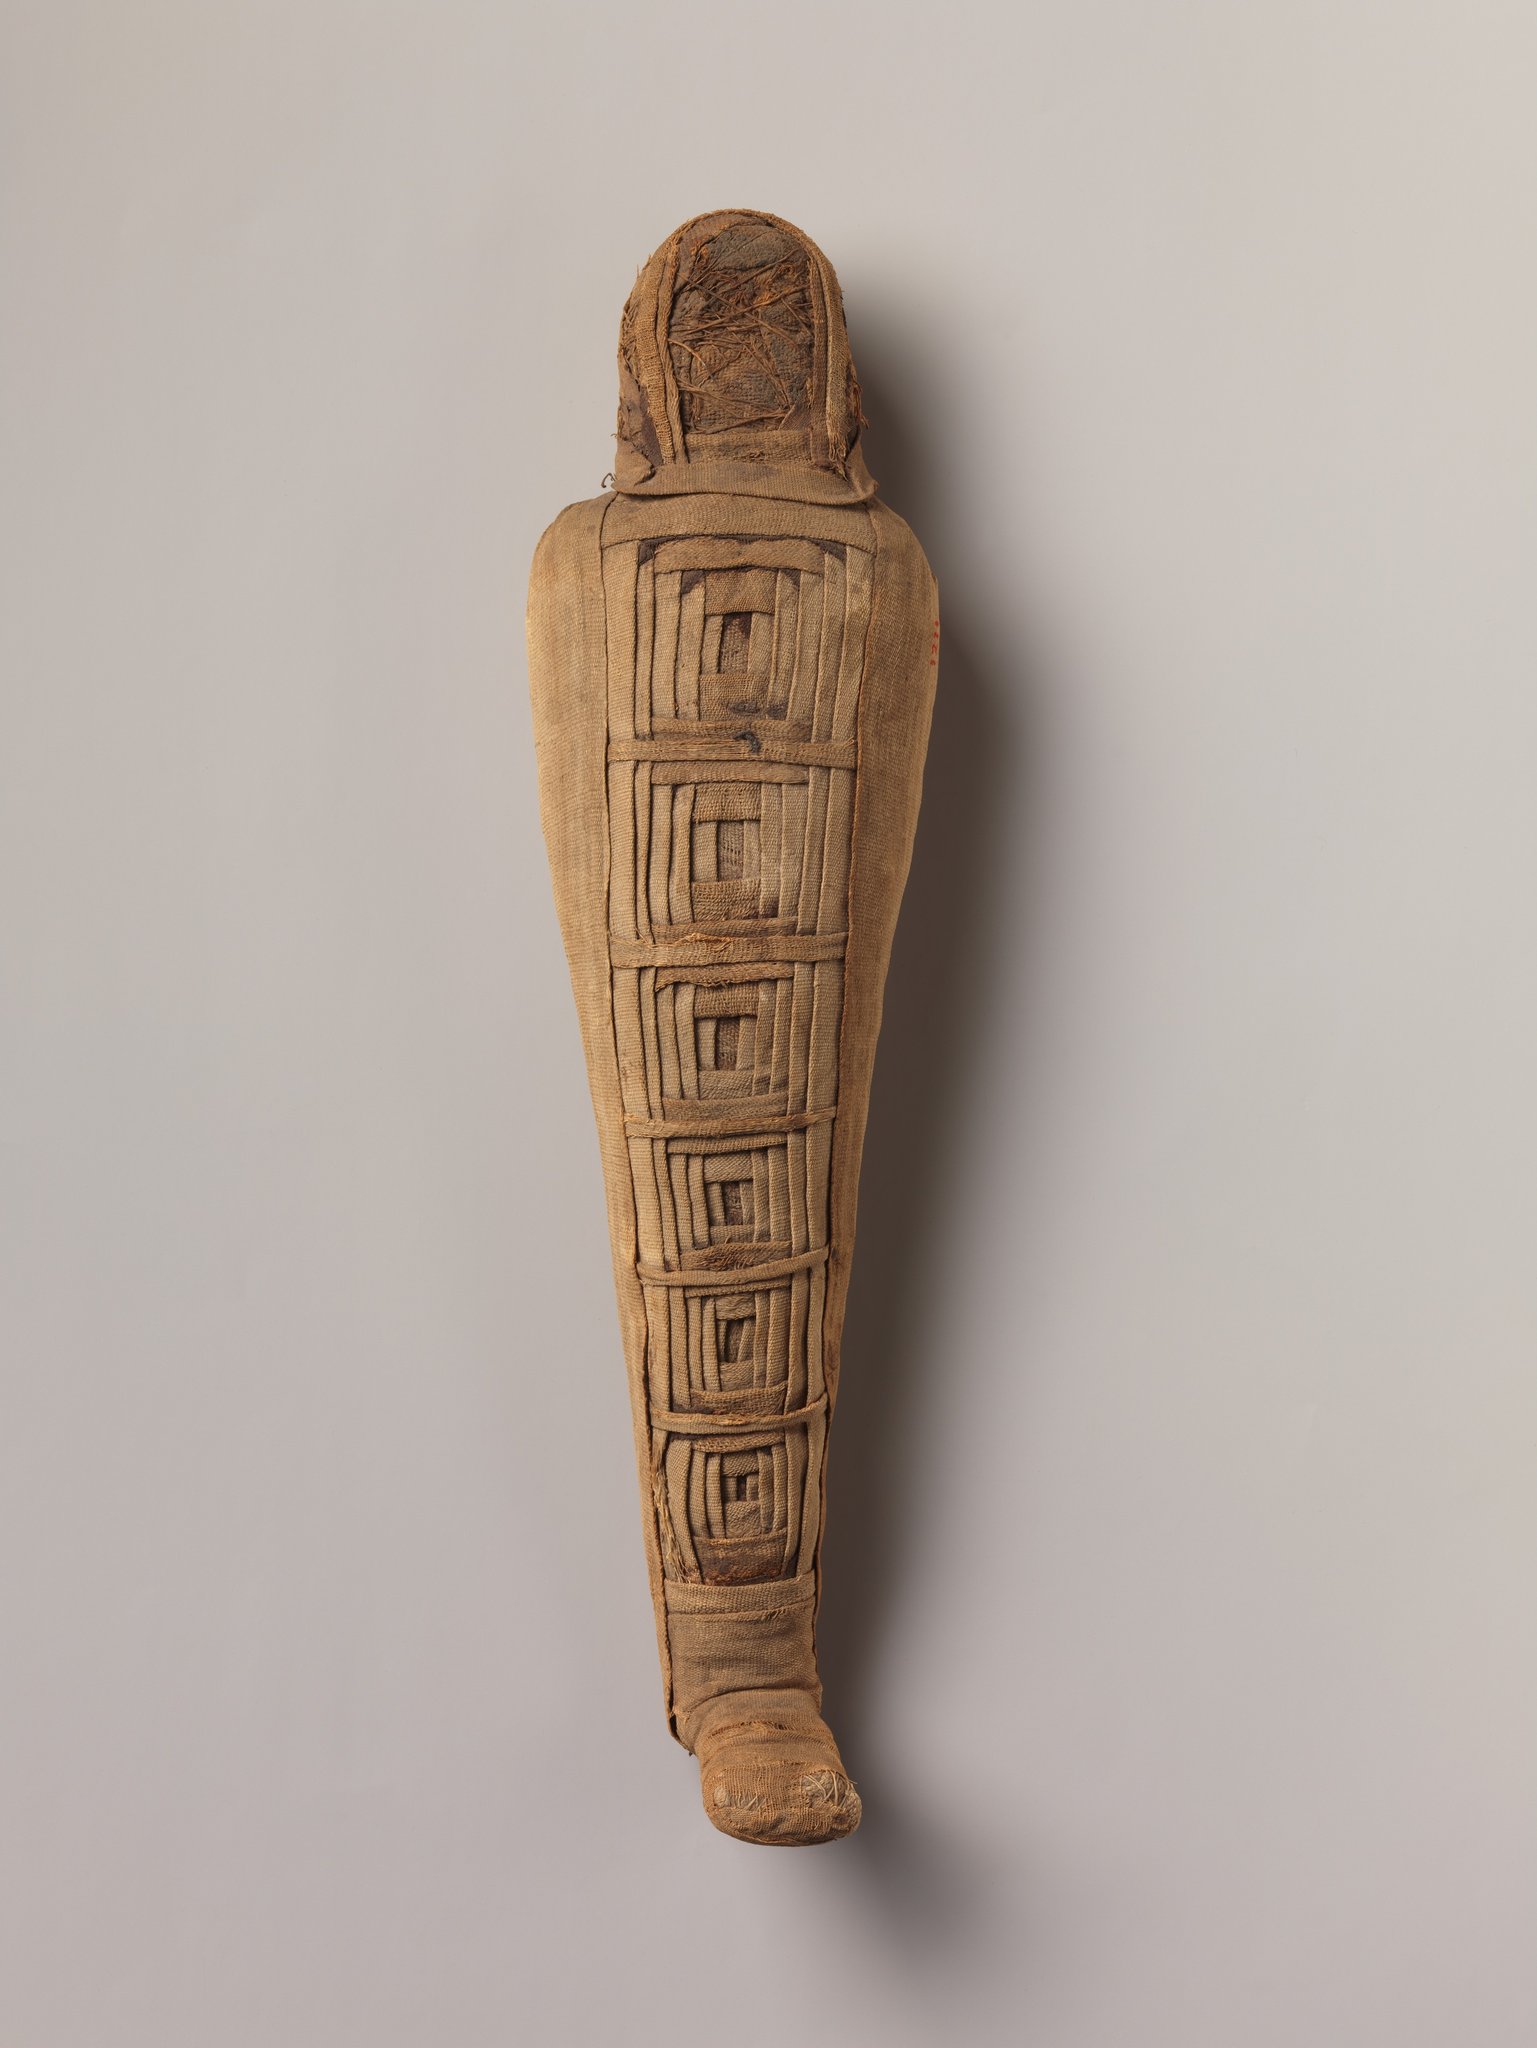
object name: mummy, falcon shaped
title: Sacred animal mummy in the form of a falcon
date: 400 BCE-100 CE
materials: linen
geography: egypt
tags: mummies